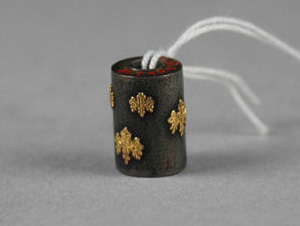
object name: ojime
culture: japanese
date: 1801-1900